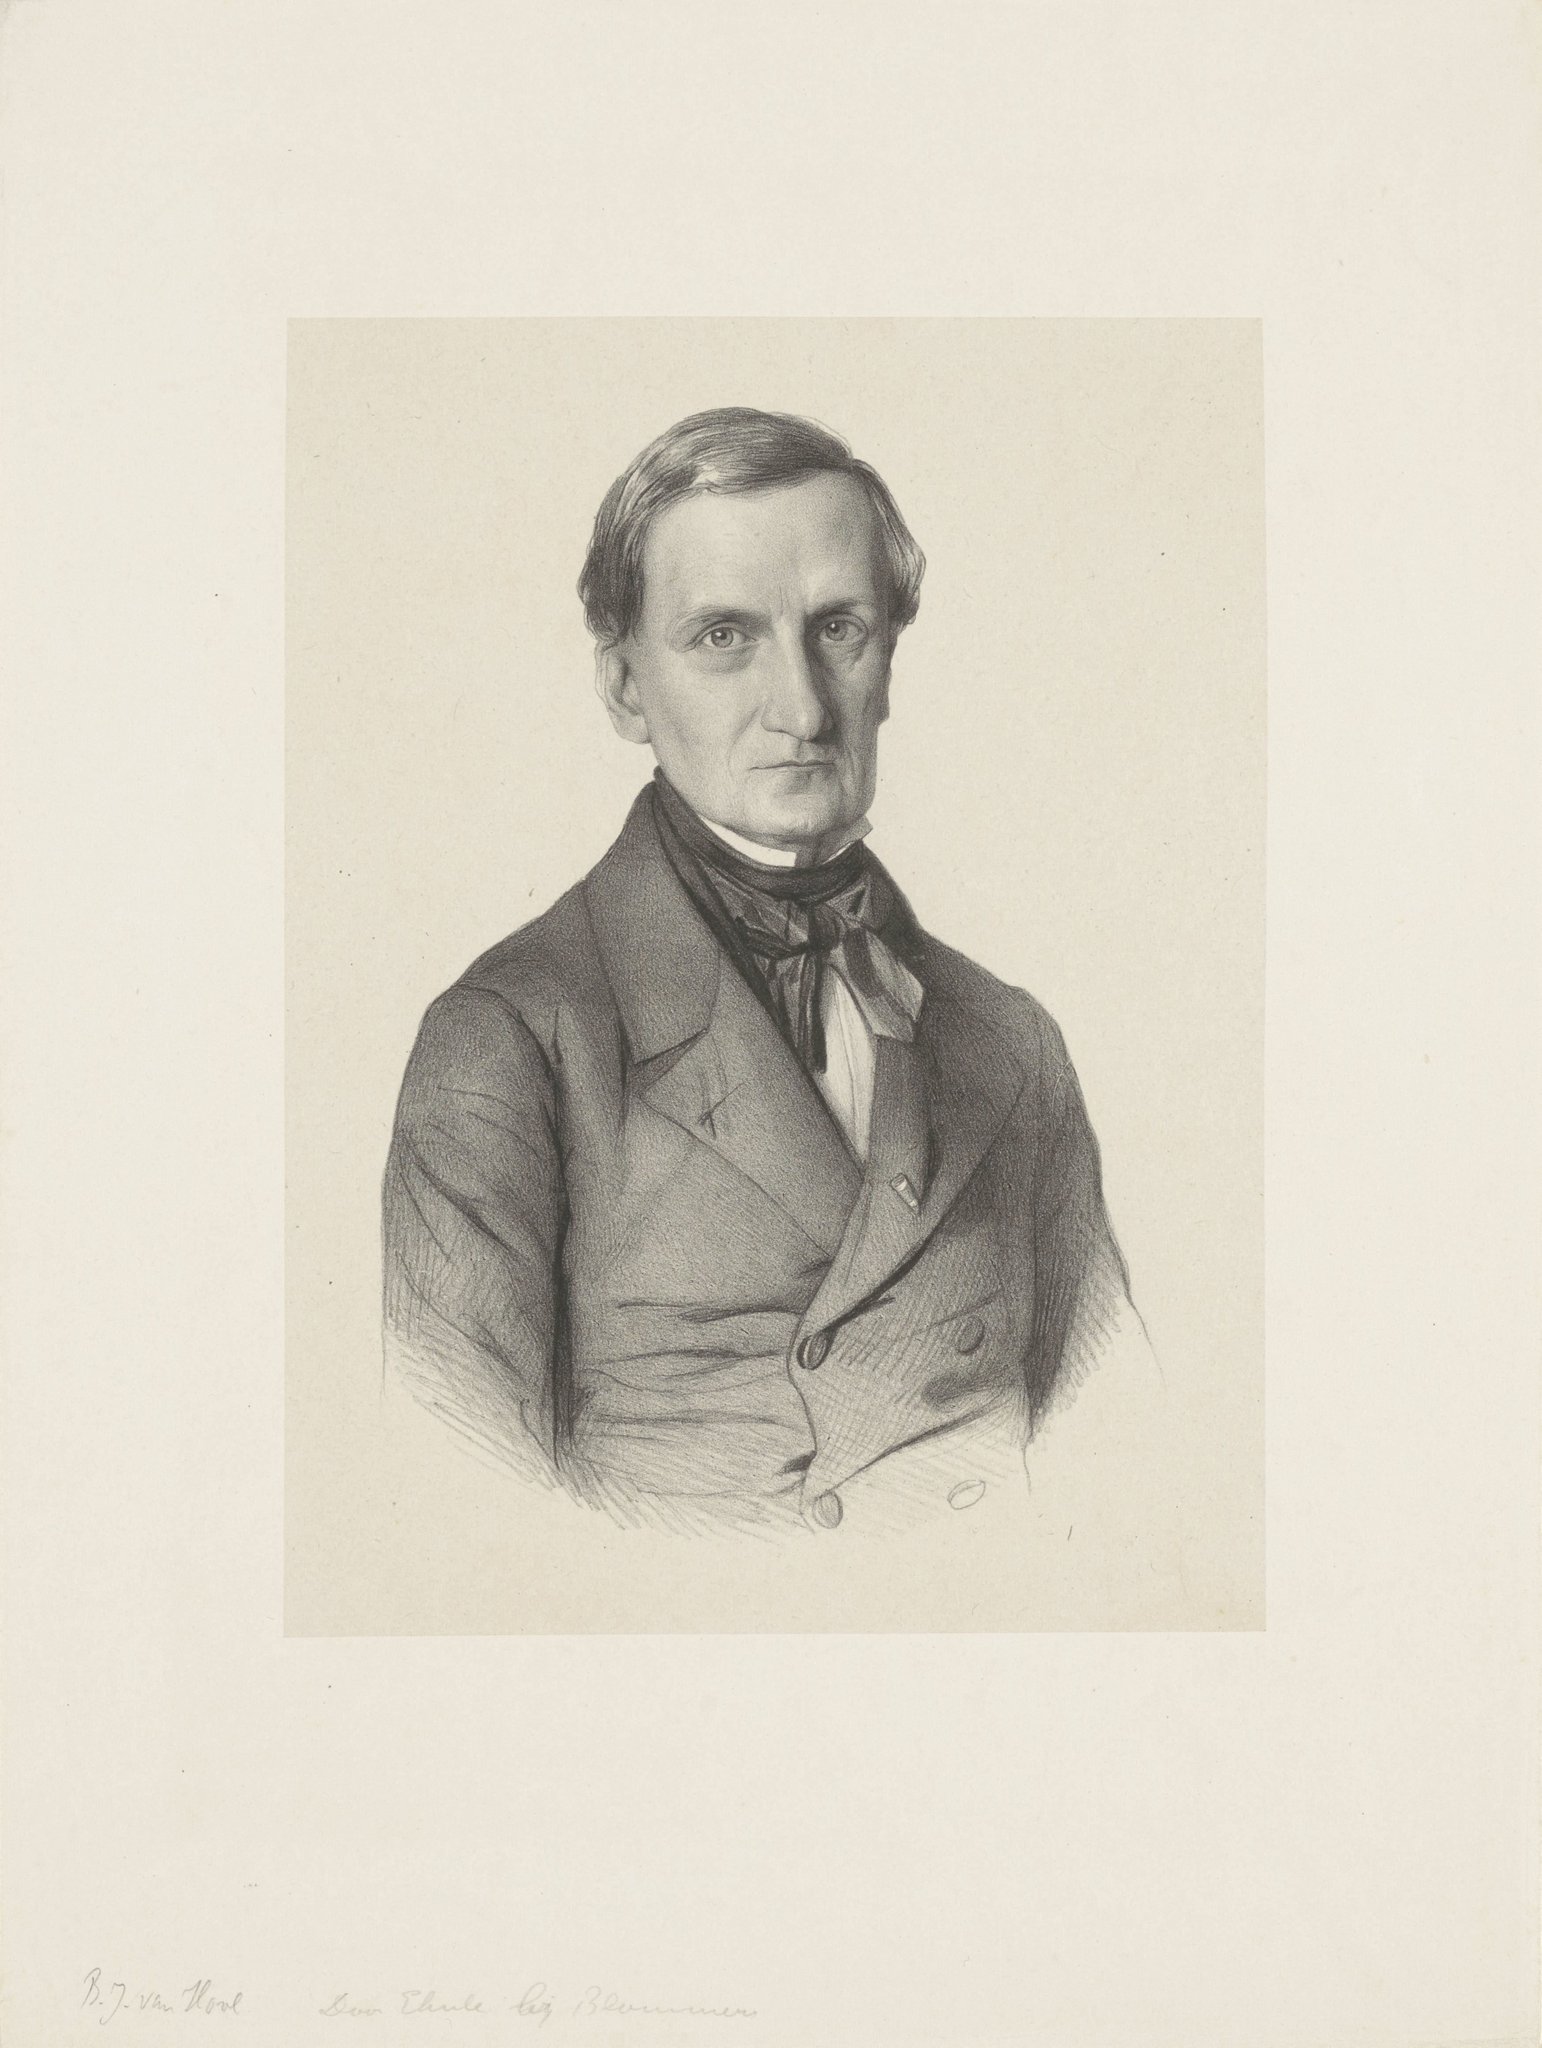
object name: print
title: Portret van Bartholomeus Johannes van Hove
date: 1842-1887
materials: paper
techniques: lithograph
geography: the hague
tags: the hague, painter, print maker, draughtsman, bartholomeus johannes van hove, historical persons (+ (full) bust portrait)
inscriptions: collector's mark: Lugt 2228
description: De geportretteerde draagt een ordeteken op de revers van zijn jas en een gestrikte das.